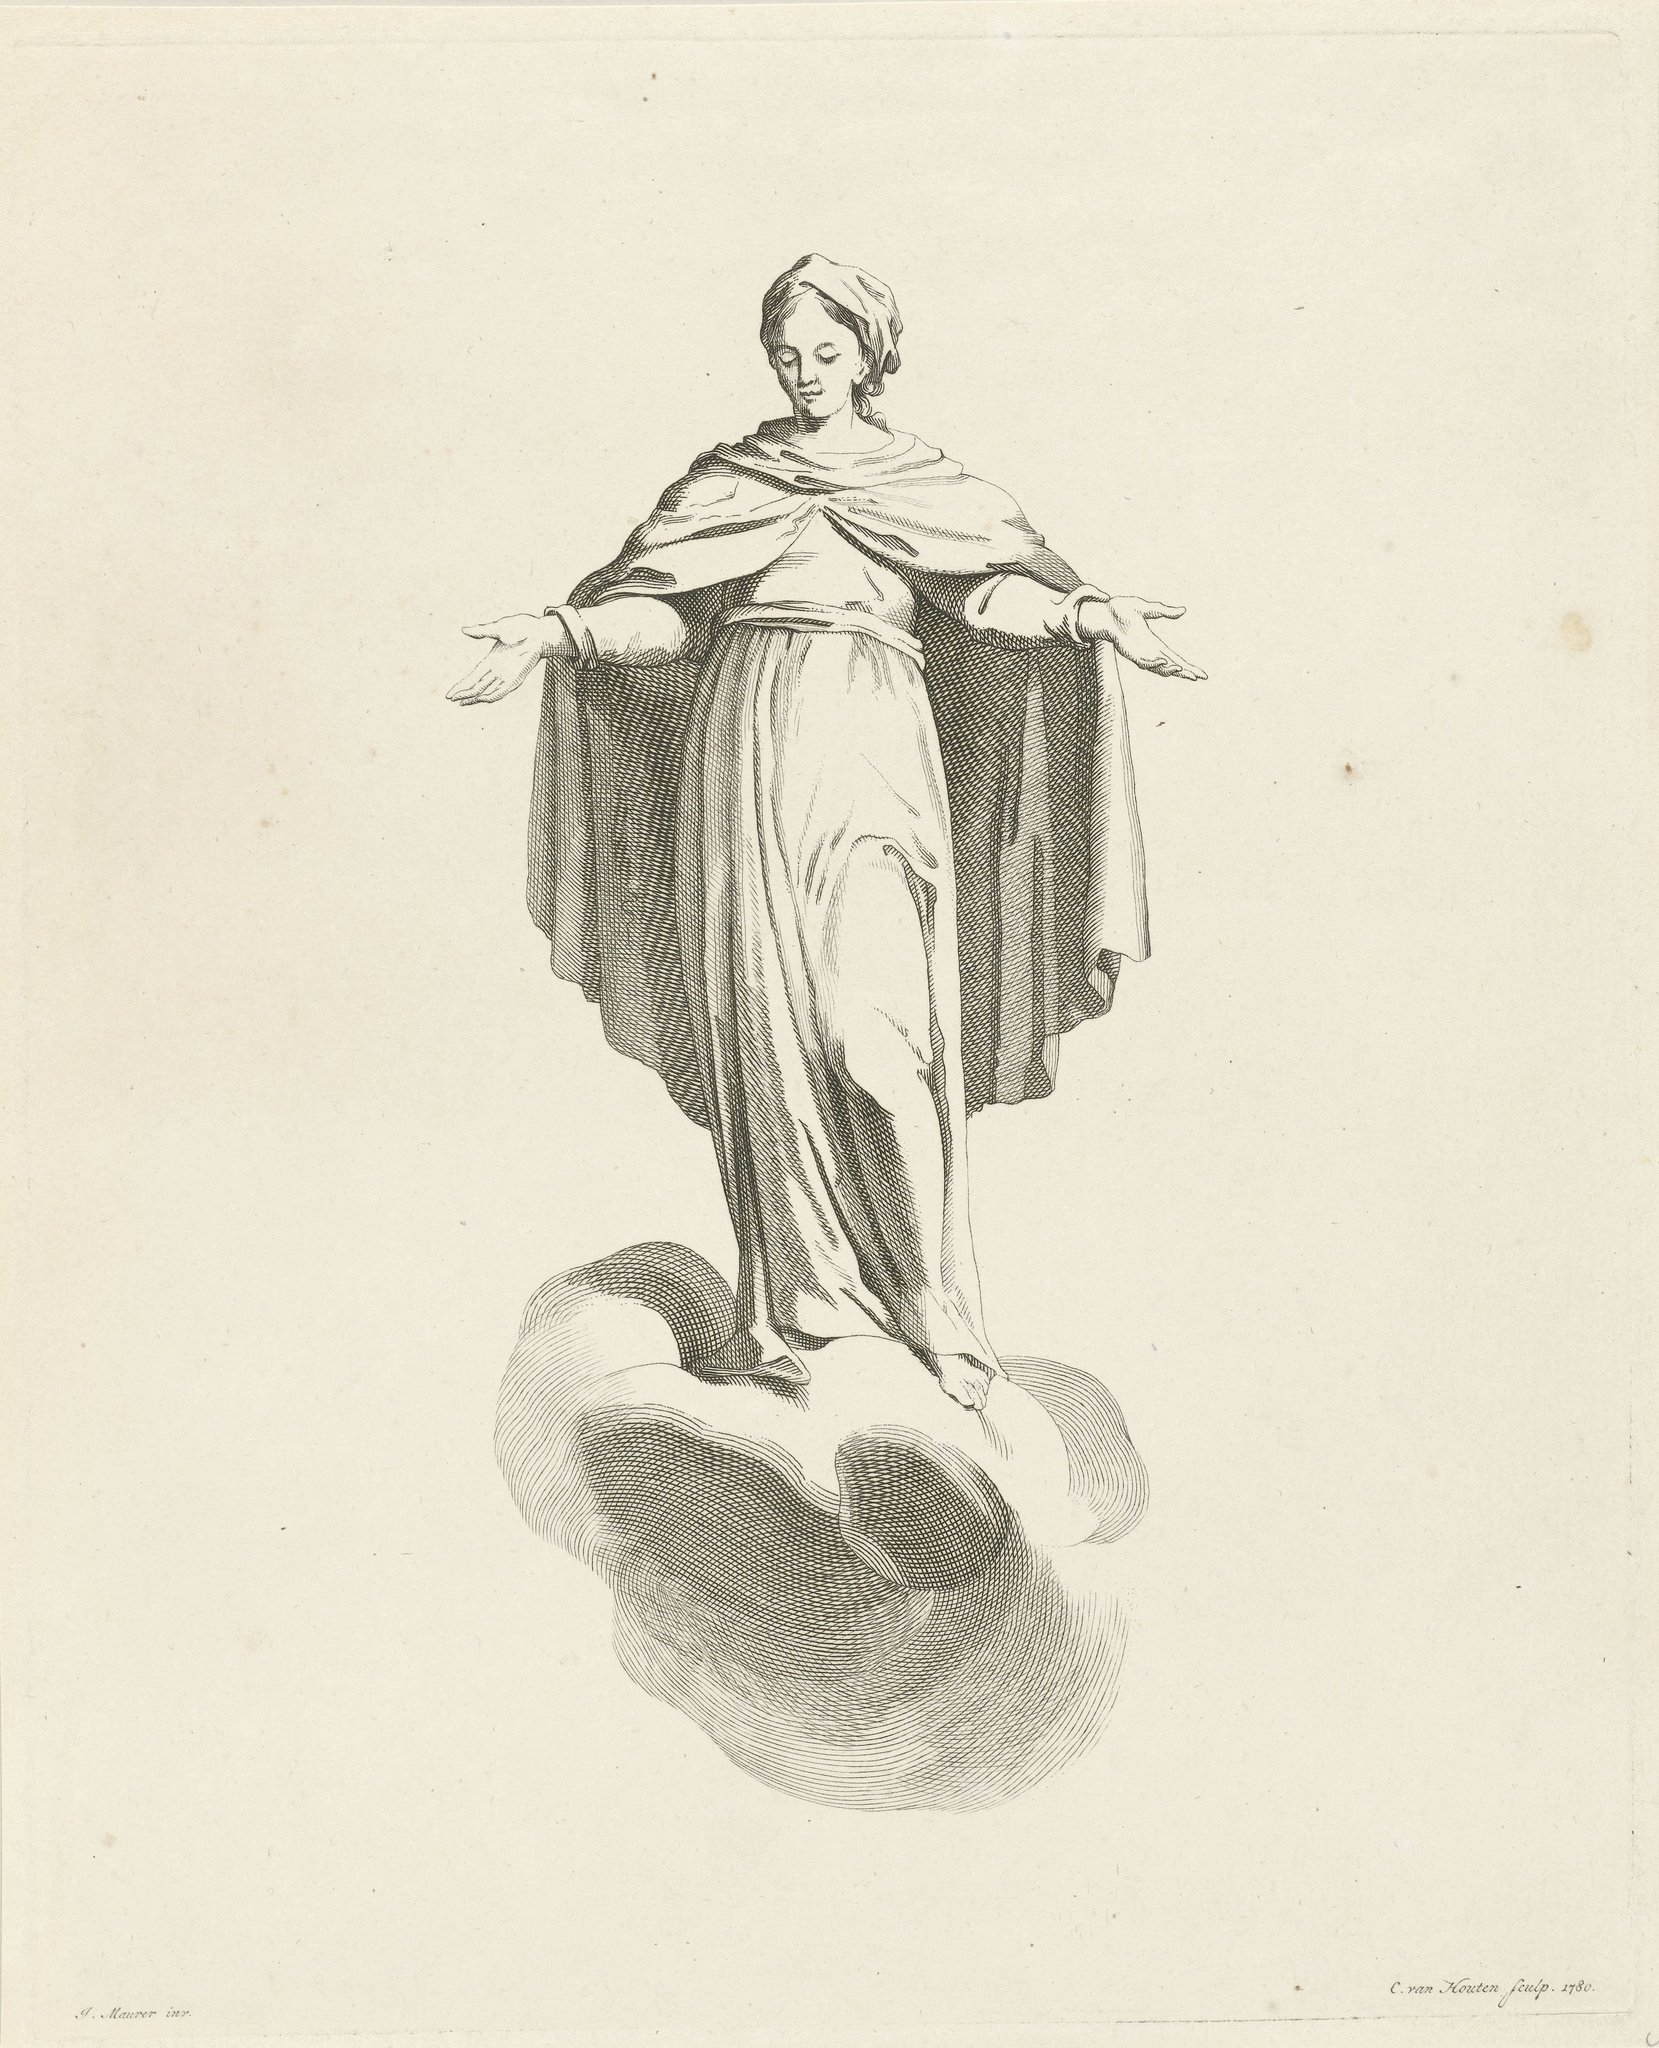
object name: print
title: Maria op een wolk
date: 1780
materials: paper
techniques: engraving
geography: utrecht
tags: madonna (i.e. mary with the christ-child) in the air, or on the clouds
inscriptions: inscription: ‘Grieth’, collector's mark: Lugt 2228